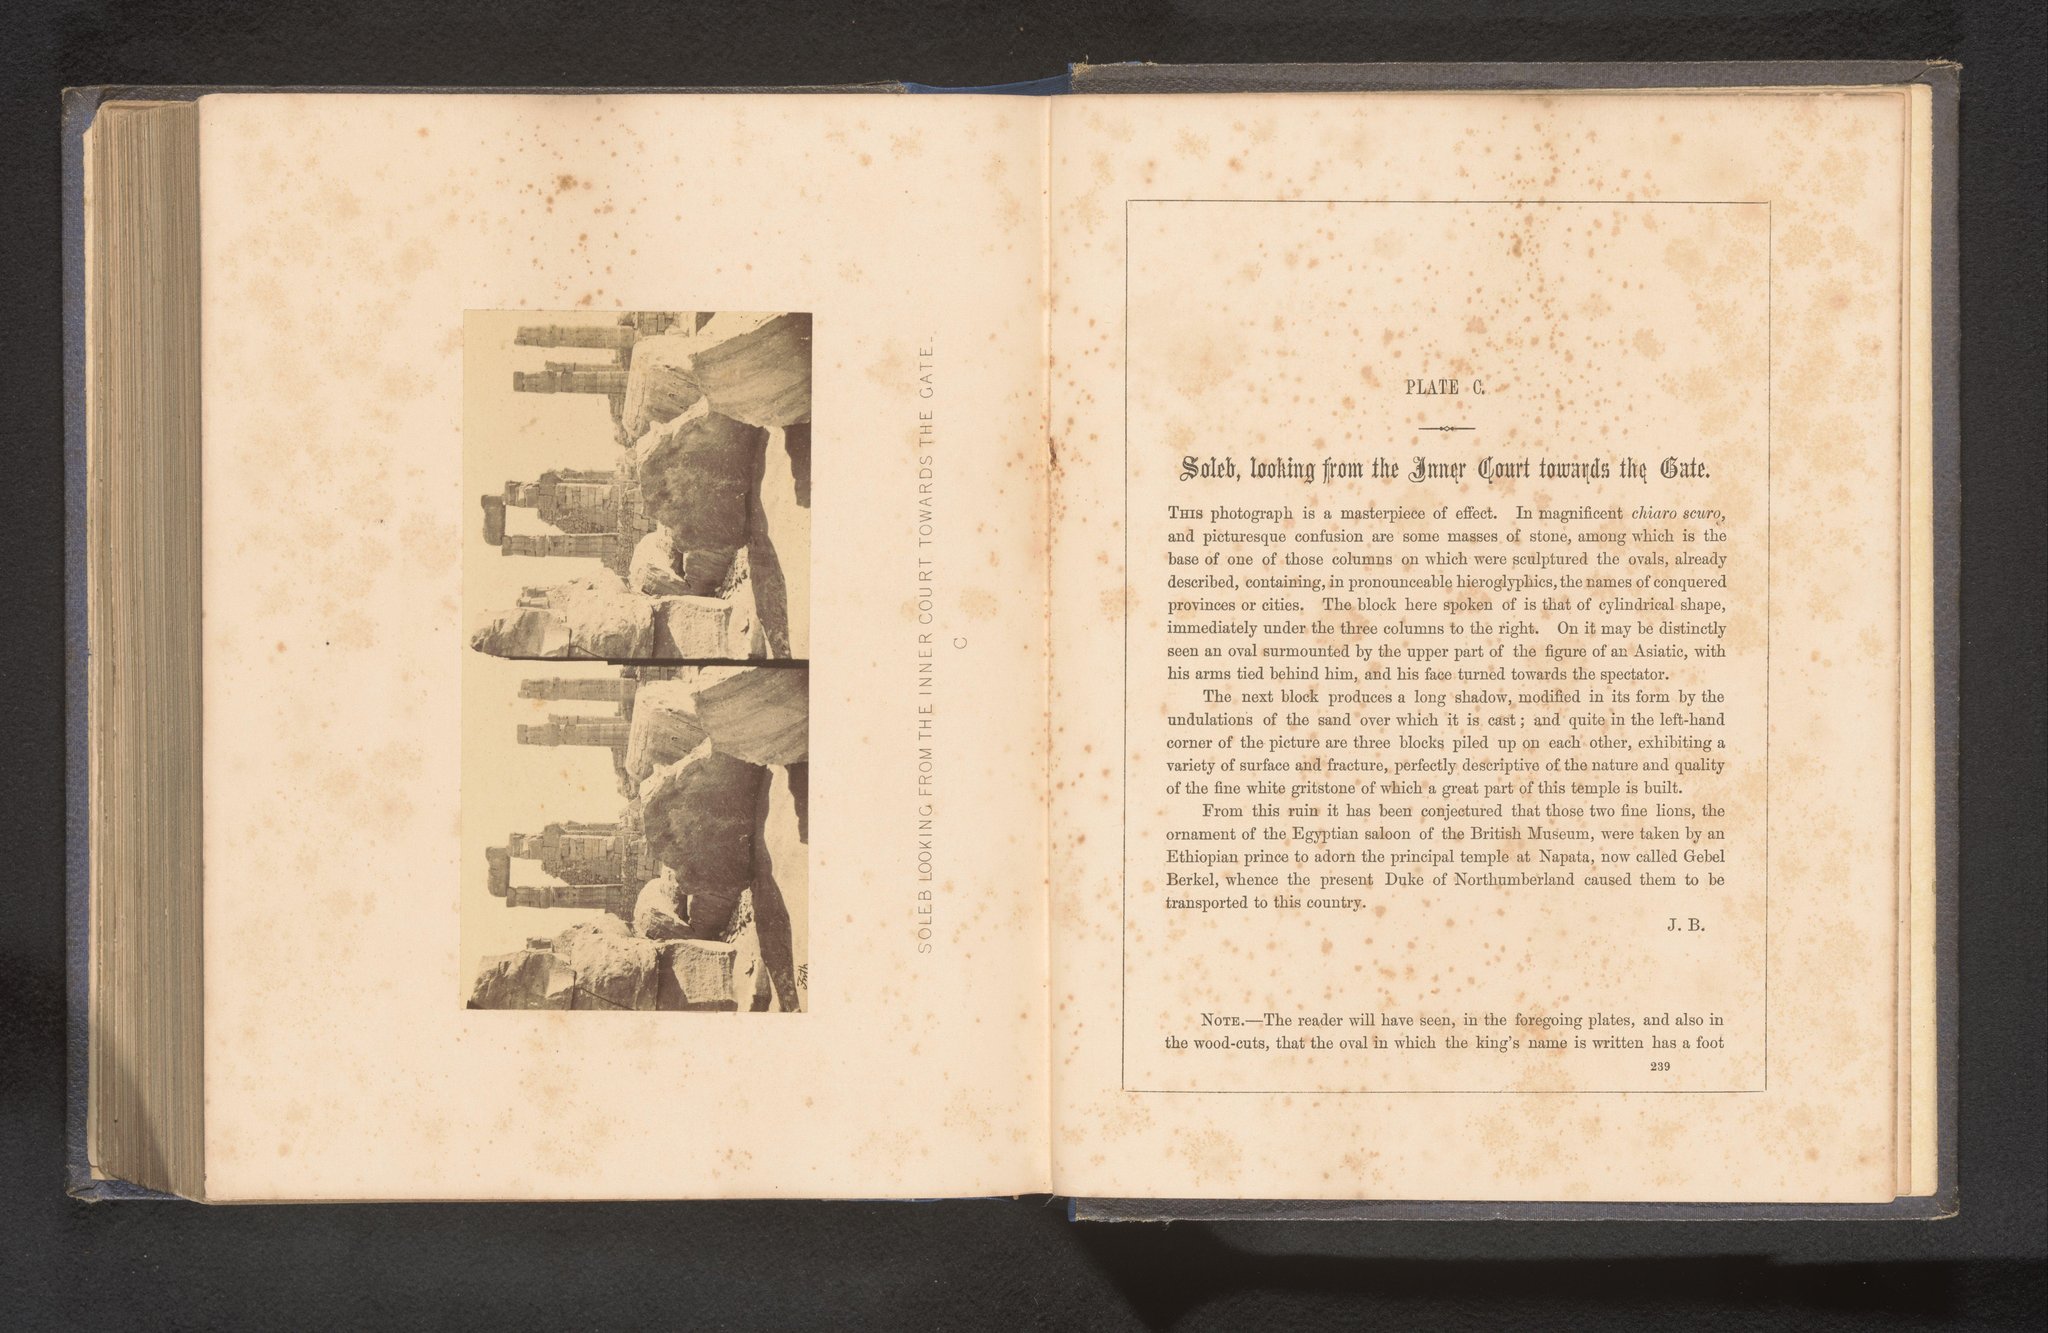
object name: stereograph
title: Ruïne van de tempel van Amenhotep III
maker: francis frith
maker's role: publisher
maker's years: 1822-1898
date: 1857-1862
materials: photographic support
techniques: albumen print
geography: north africa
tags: the early christian churches, e.g. armenians, copts, syrians, capital (~ column, pillar)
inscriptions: name: ‘Frith’, number: ‘C’